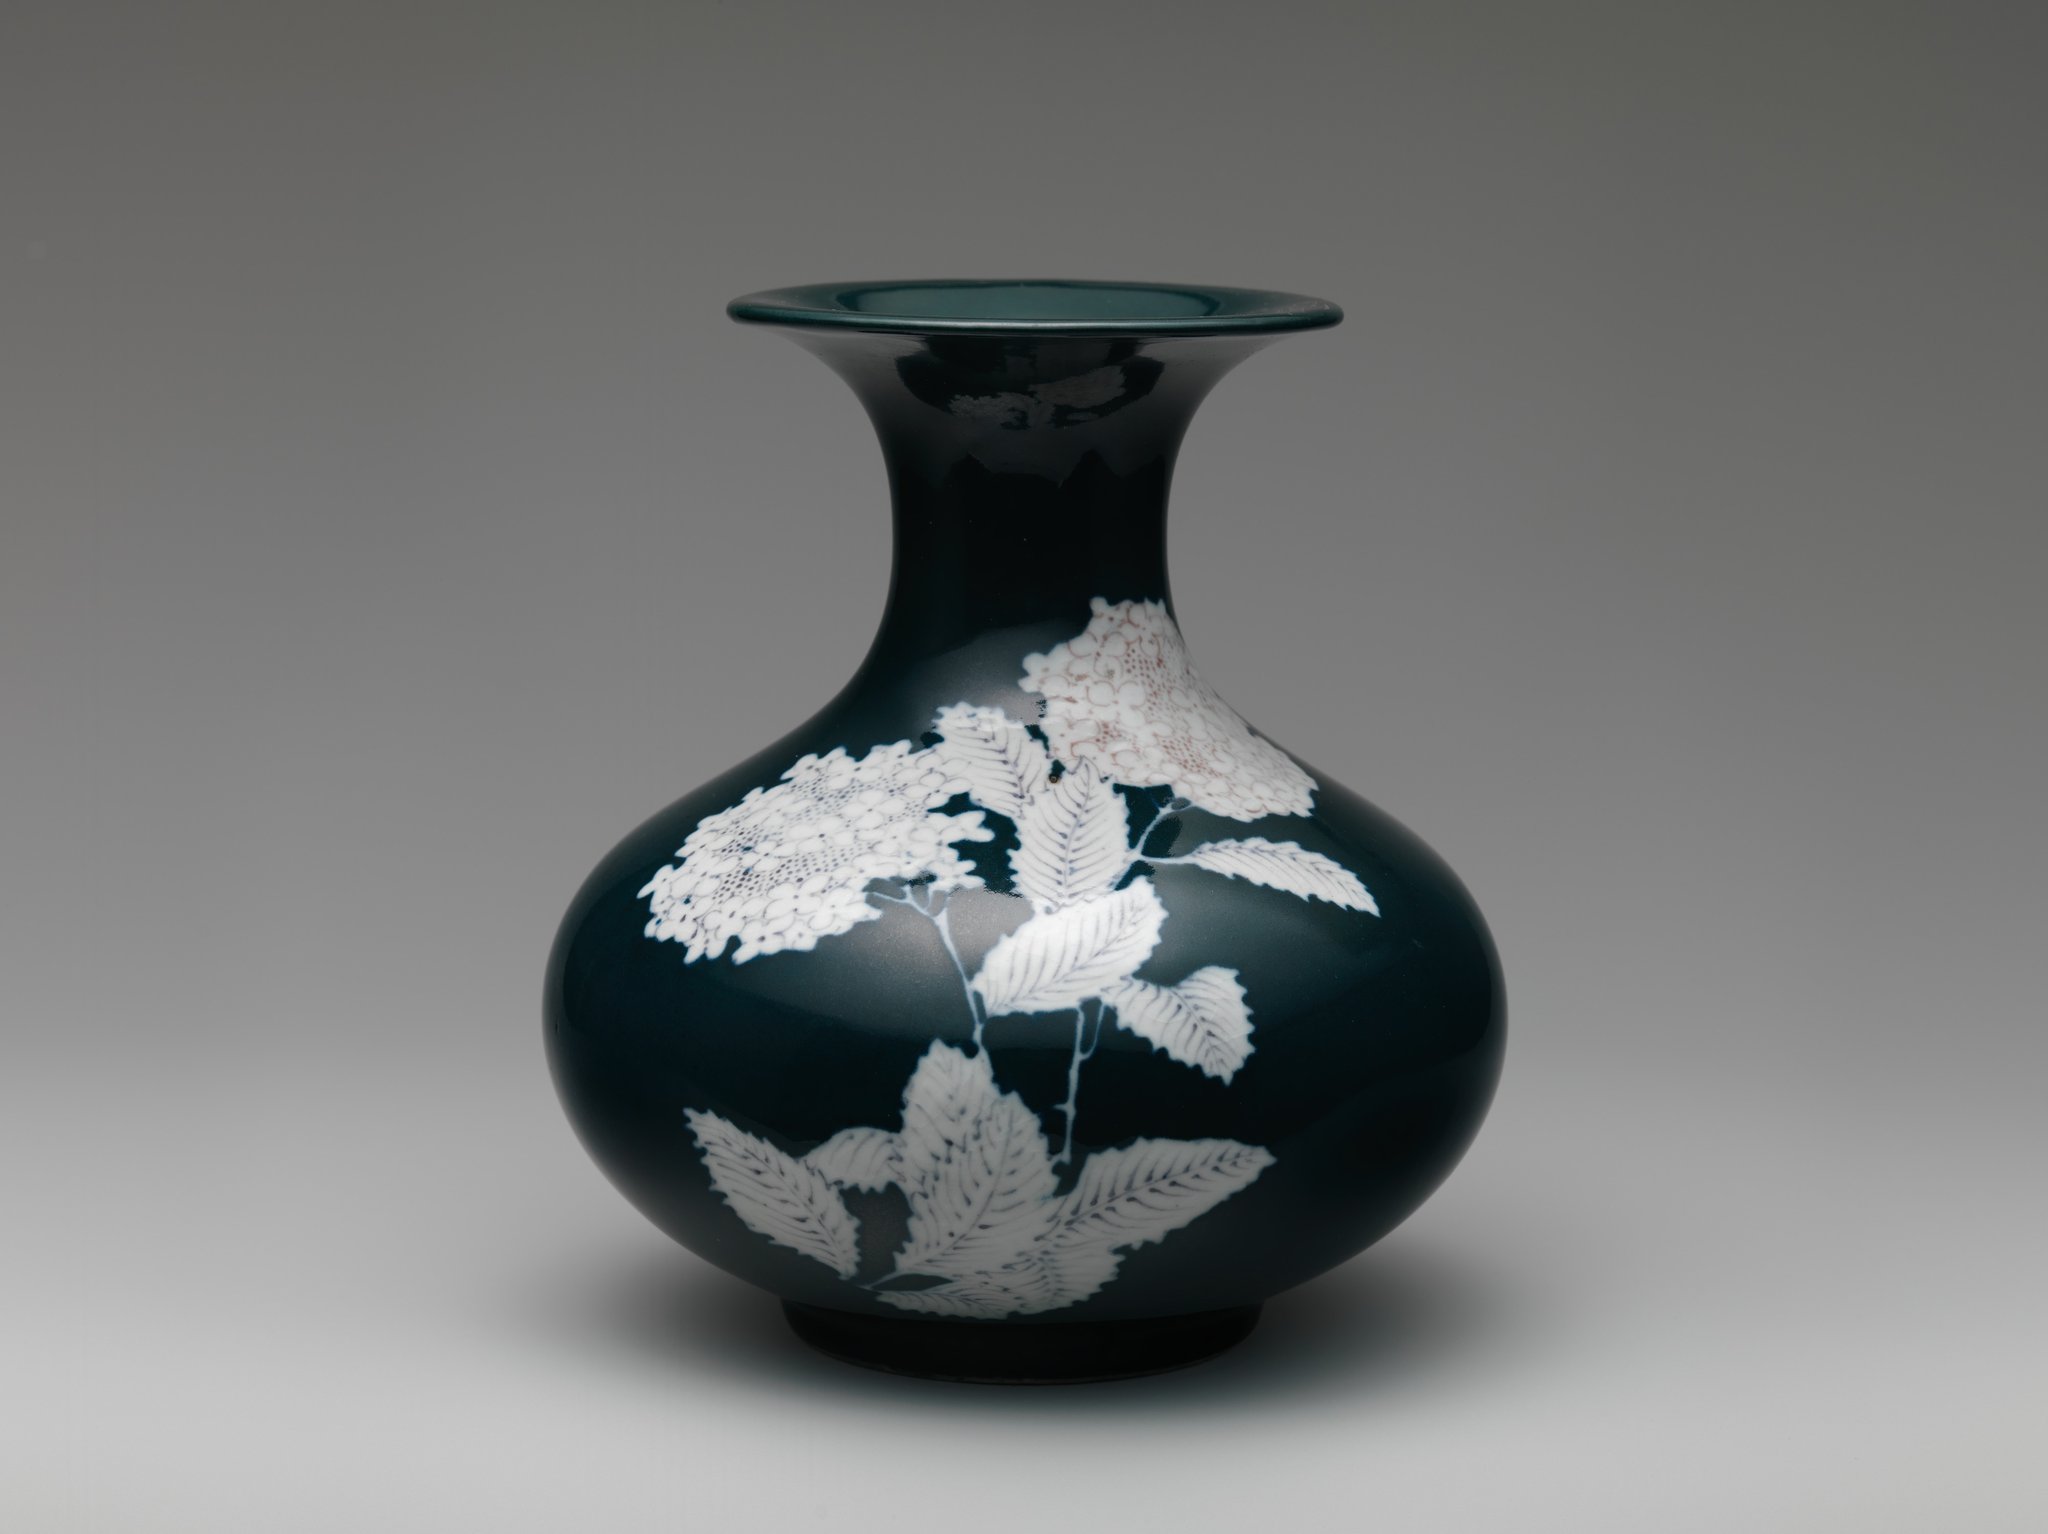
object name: vase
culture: japanese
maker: makuzu kōzan i (miyagawa toranosuke)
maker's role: artist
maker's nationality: japanese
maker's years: 1842-1916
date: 1801-1900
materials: enamel, glaze, porcelain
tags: flowers,leaves